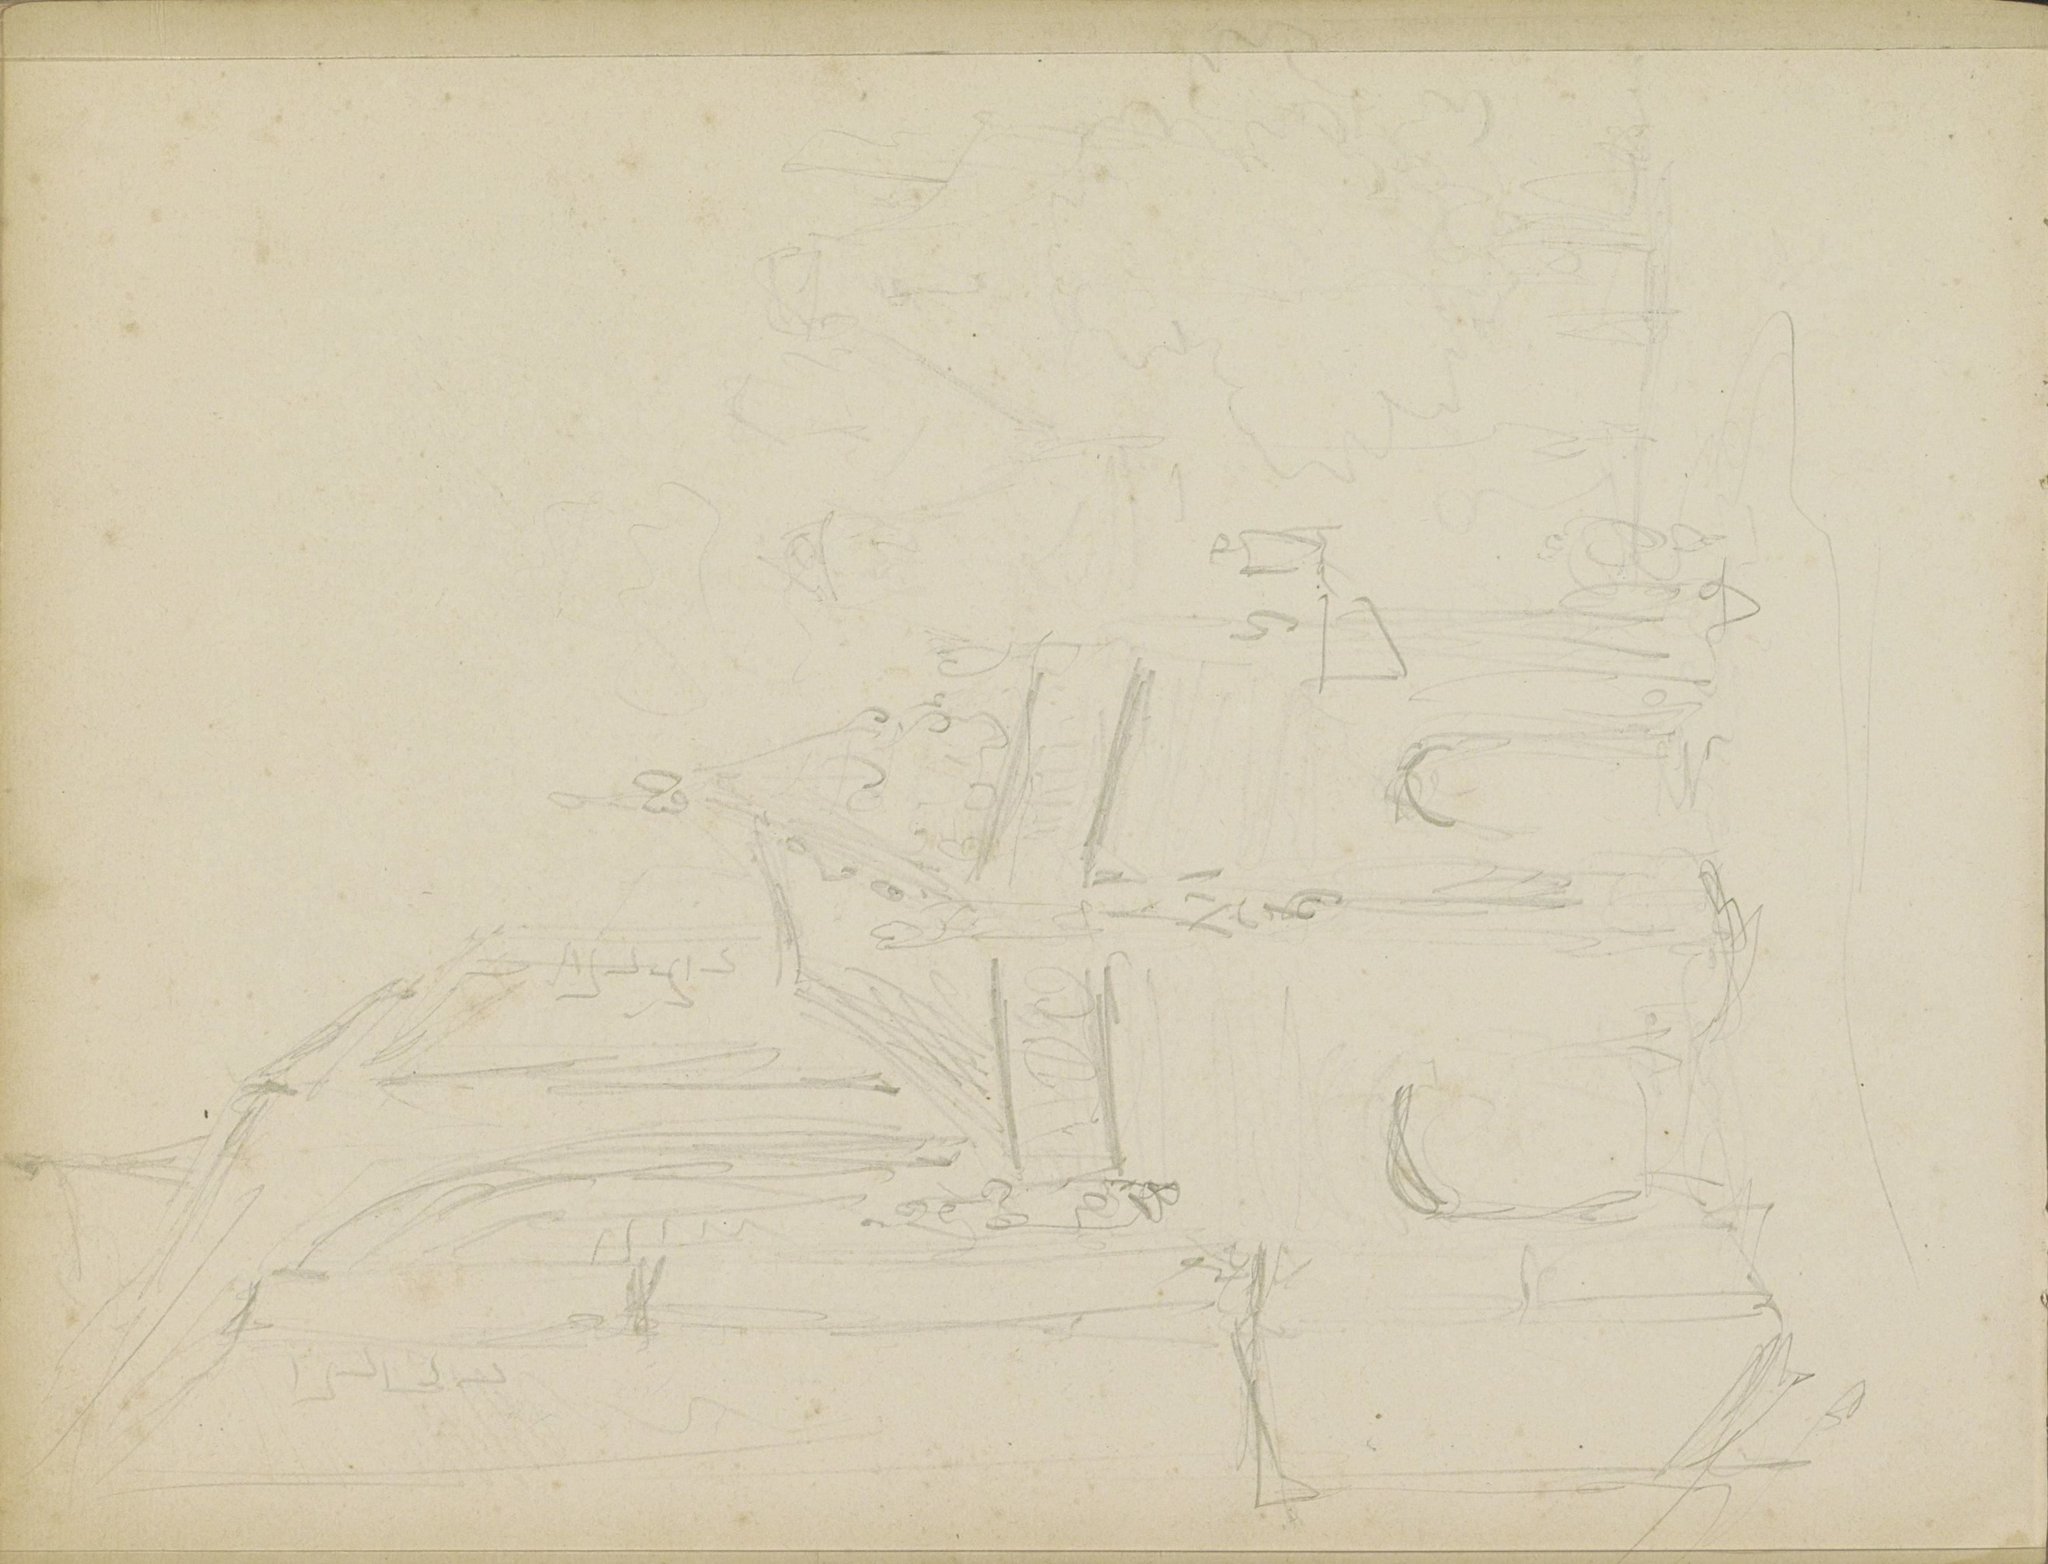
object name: sketchbook leaf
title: Stadsgezicht met een kerk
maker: adrianus eversen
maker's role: draughtsman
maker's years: 1818-1897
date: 1828-1897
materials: paper, pencil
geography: netherlands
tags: urban housing, city-view, and landscape with man-made constructions, church (exterior)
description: Links een gebouw met rondbogen voor een kerk. In de verte gebouwen met topgevels. Blad 16 verso uit een schetsboek met 41 bladen.